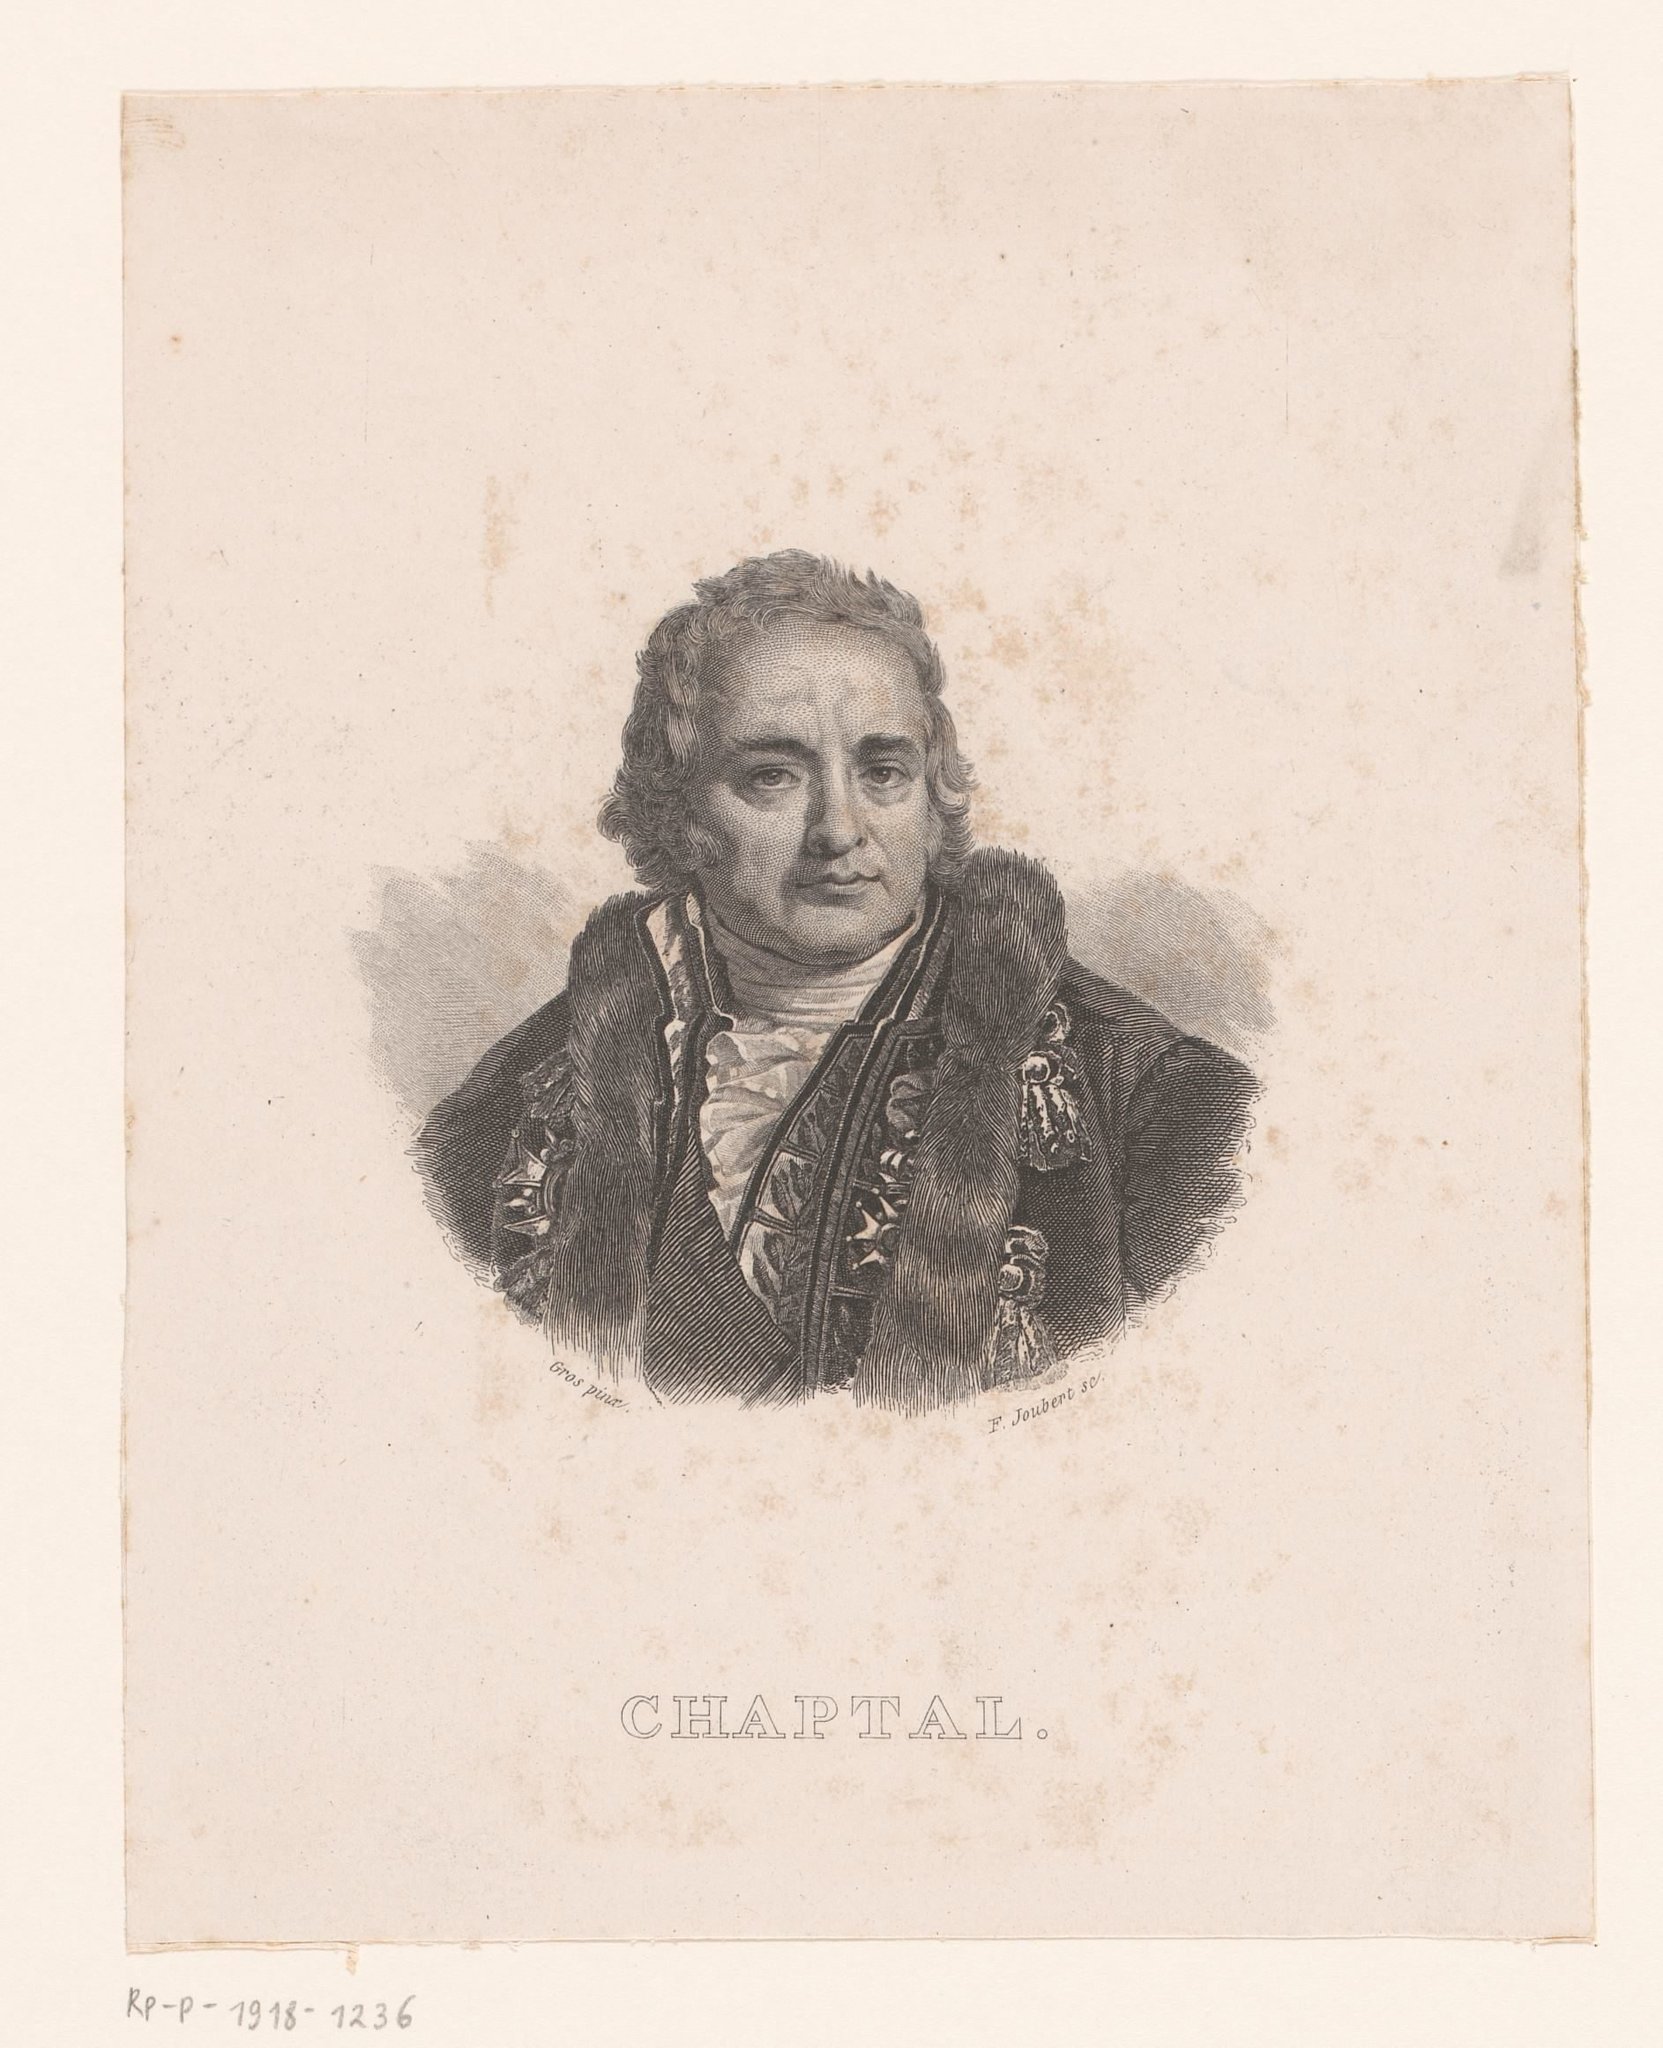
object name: print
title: Chaptal.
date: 1820-1884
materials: paper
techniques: etching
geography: france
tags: paris, politician, jean-antoine chaptal, historical persons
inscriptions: collector's mark: Lugt 2233